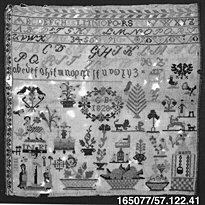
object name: sampler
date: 1828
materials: silk, wool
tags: animals,birds